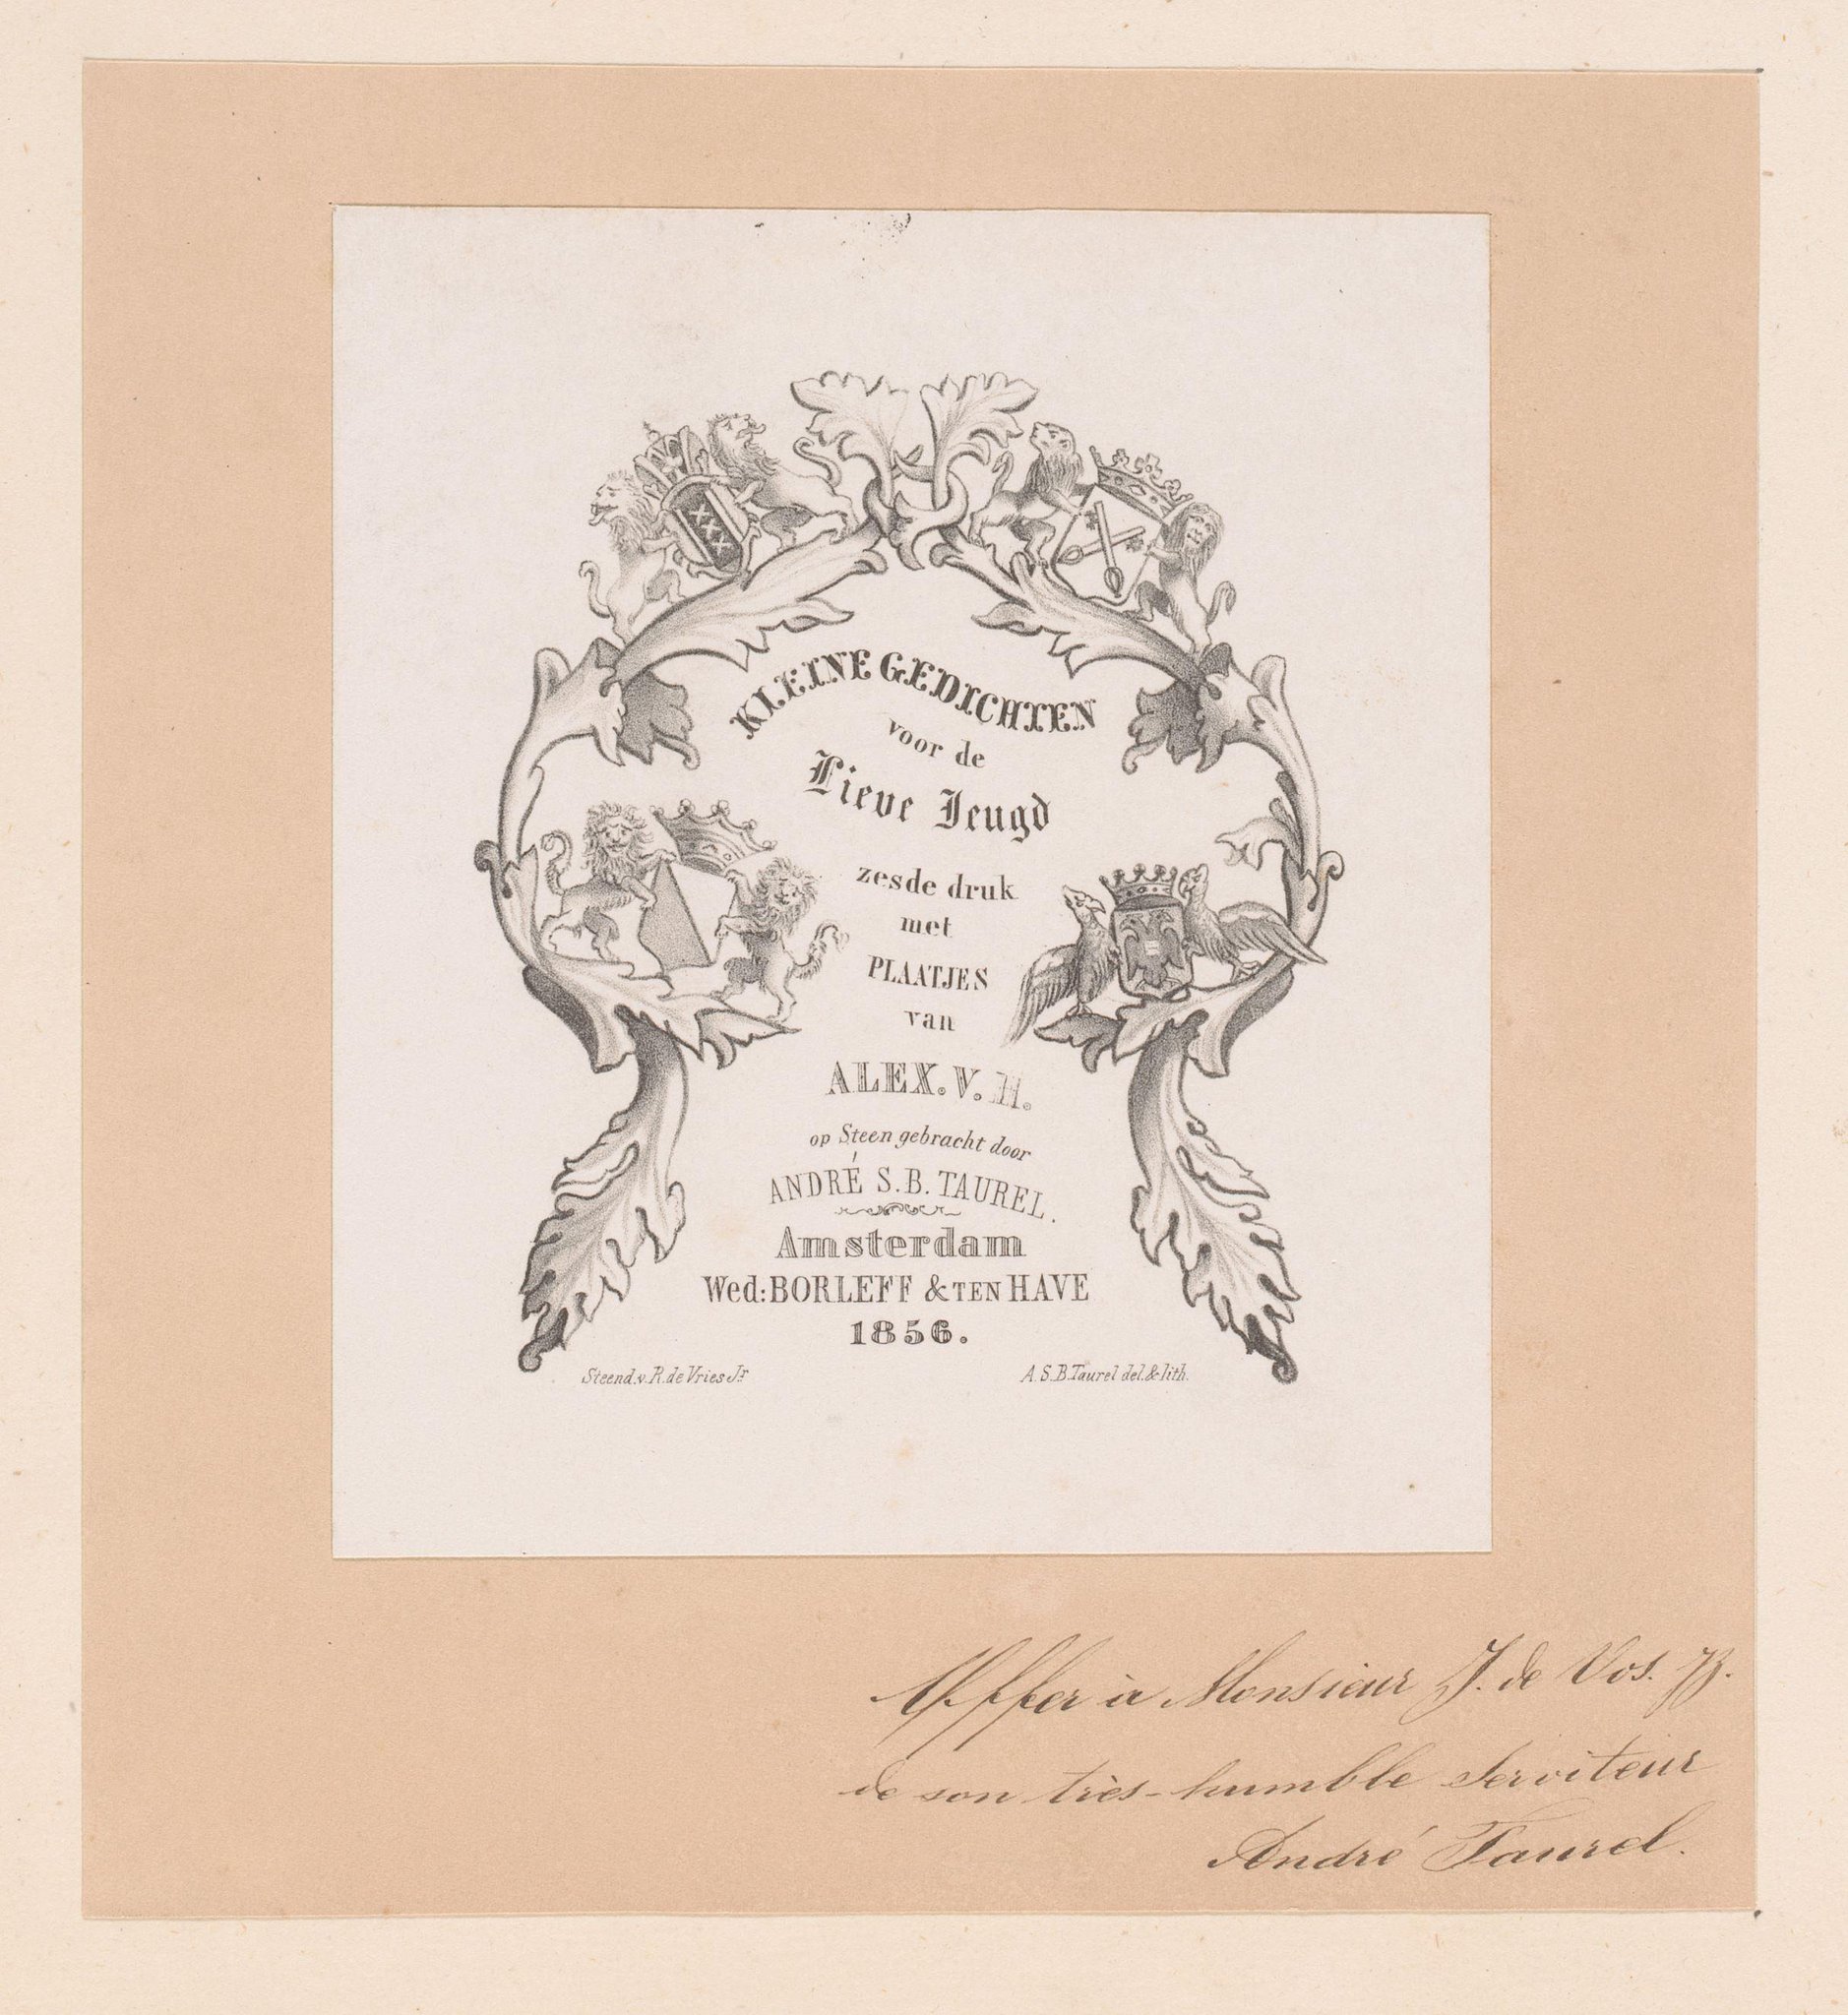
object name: titelblad, titelpagina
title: Titelpagina voor: S.n., Kleine gedichten voor de Lieve Jeugd, 1856.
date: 1856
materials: paper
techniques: lithograph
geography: amsterdam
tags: ornaments ~ art (+ framing decorations)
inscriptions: collector's mark: Lugt 2228, collector's mark: Lugt 2760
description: Titelpagina voor: S.n. Kleine gedichten voor de Lieve Jeugd. Amsterdam: Borleff & ten Have, weduwe, 1856.